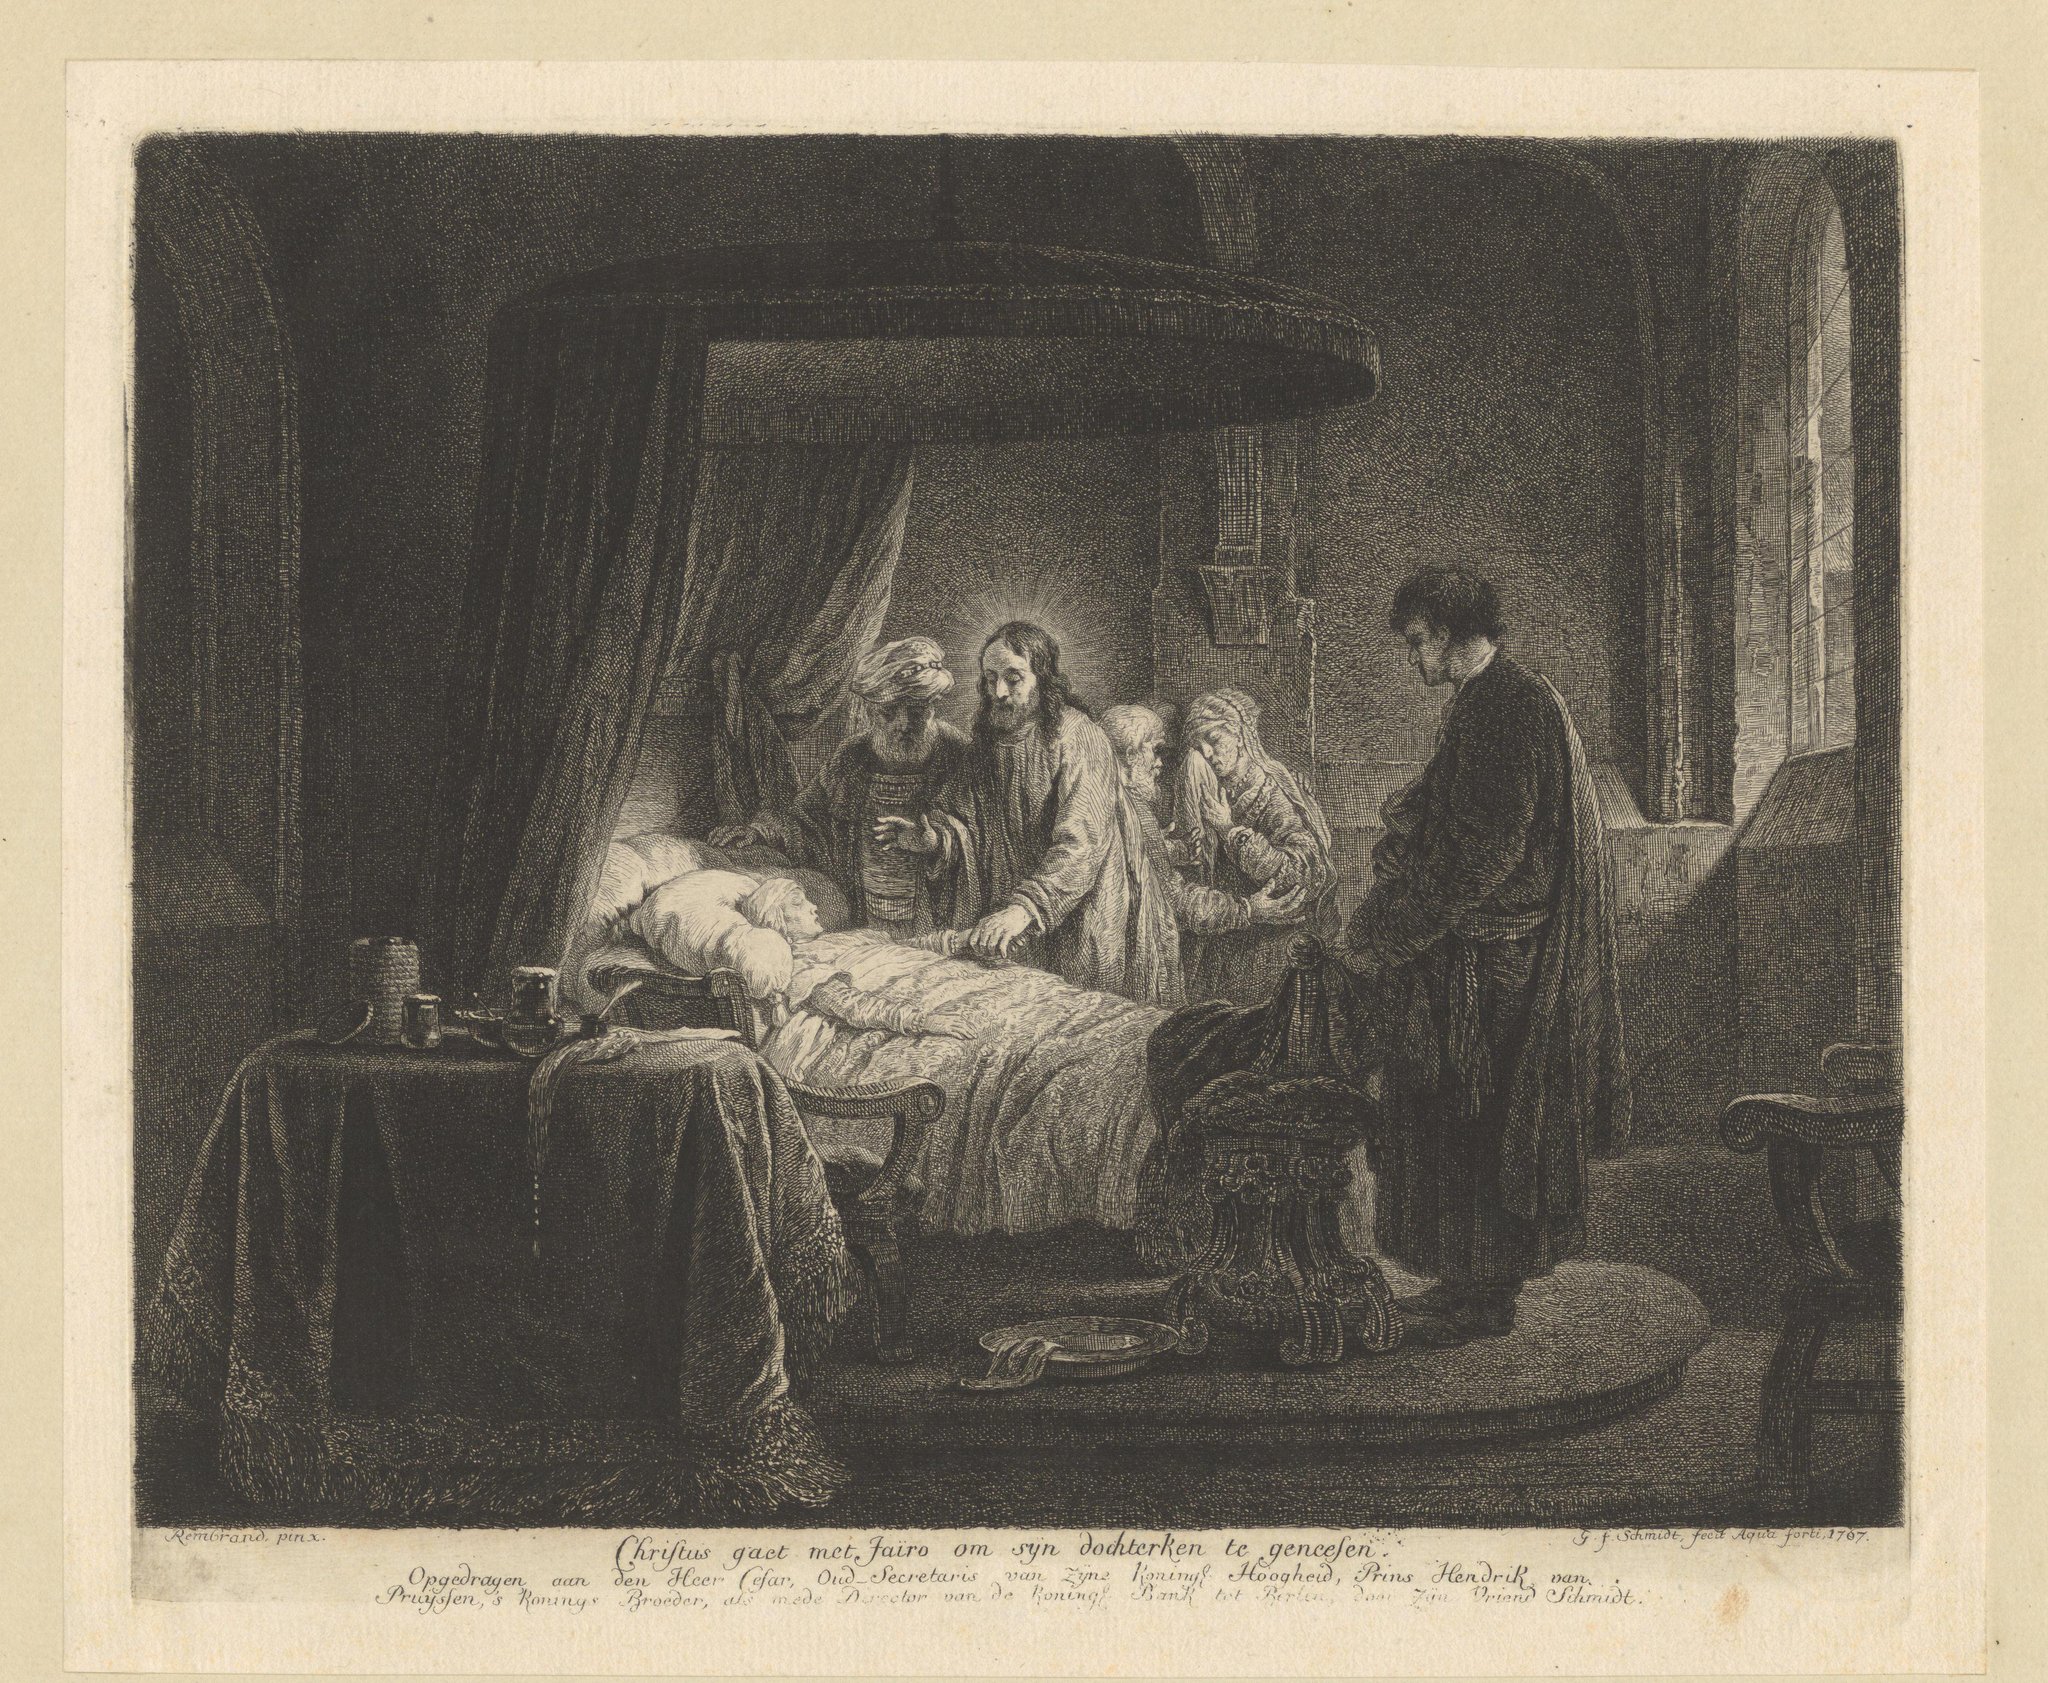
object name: print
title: Opwekking van de dochter van Jaïrus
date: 1767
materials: paper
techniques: etching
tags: raising of the daughter of jairus, who is lying in bed (matthew 9:18-19, 9:23-26; mark 5:21-24, 5:35-43; luke 8:40-42, 8:49-56)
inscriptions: collector's mark: Lugt 240